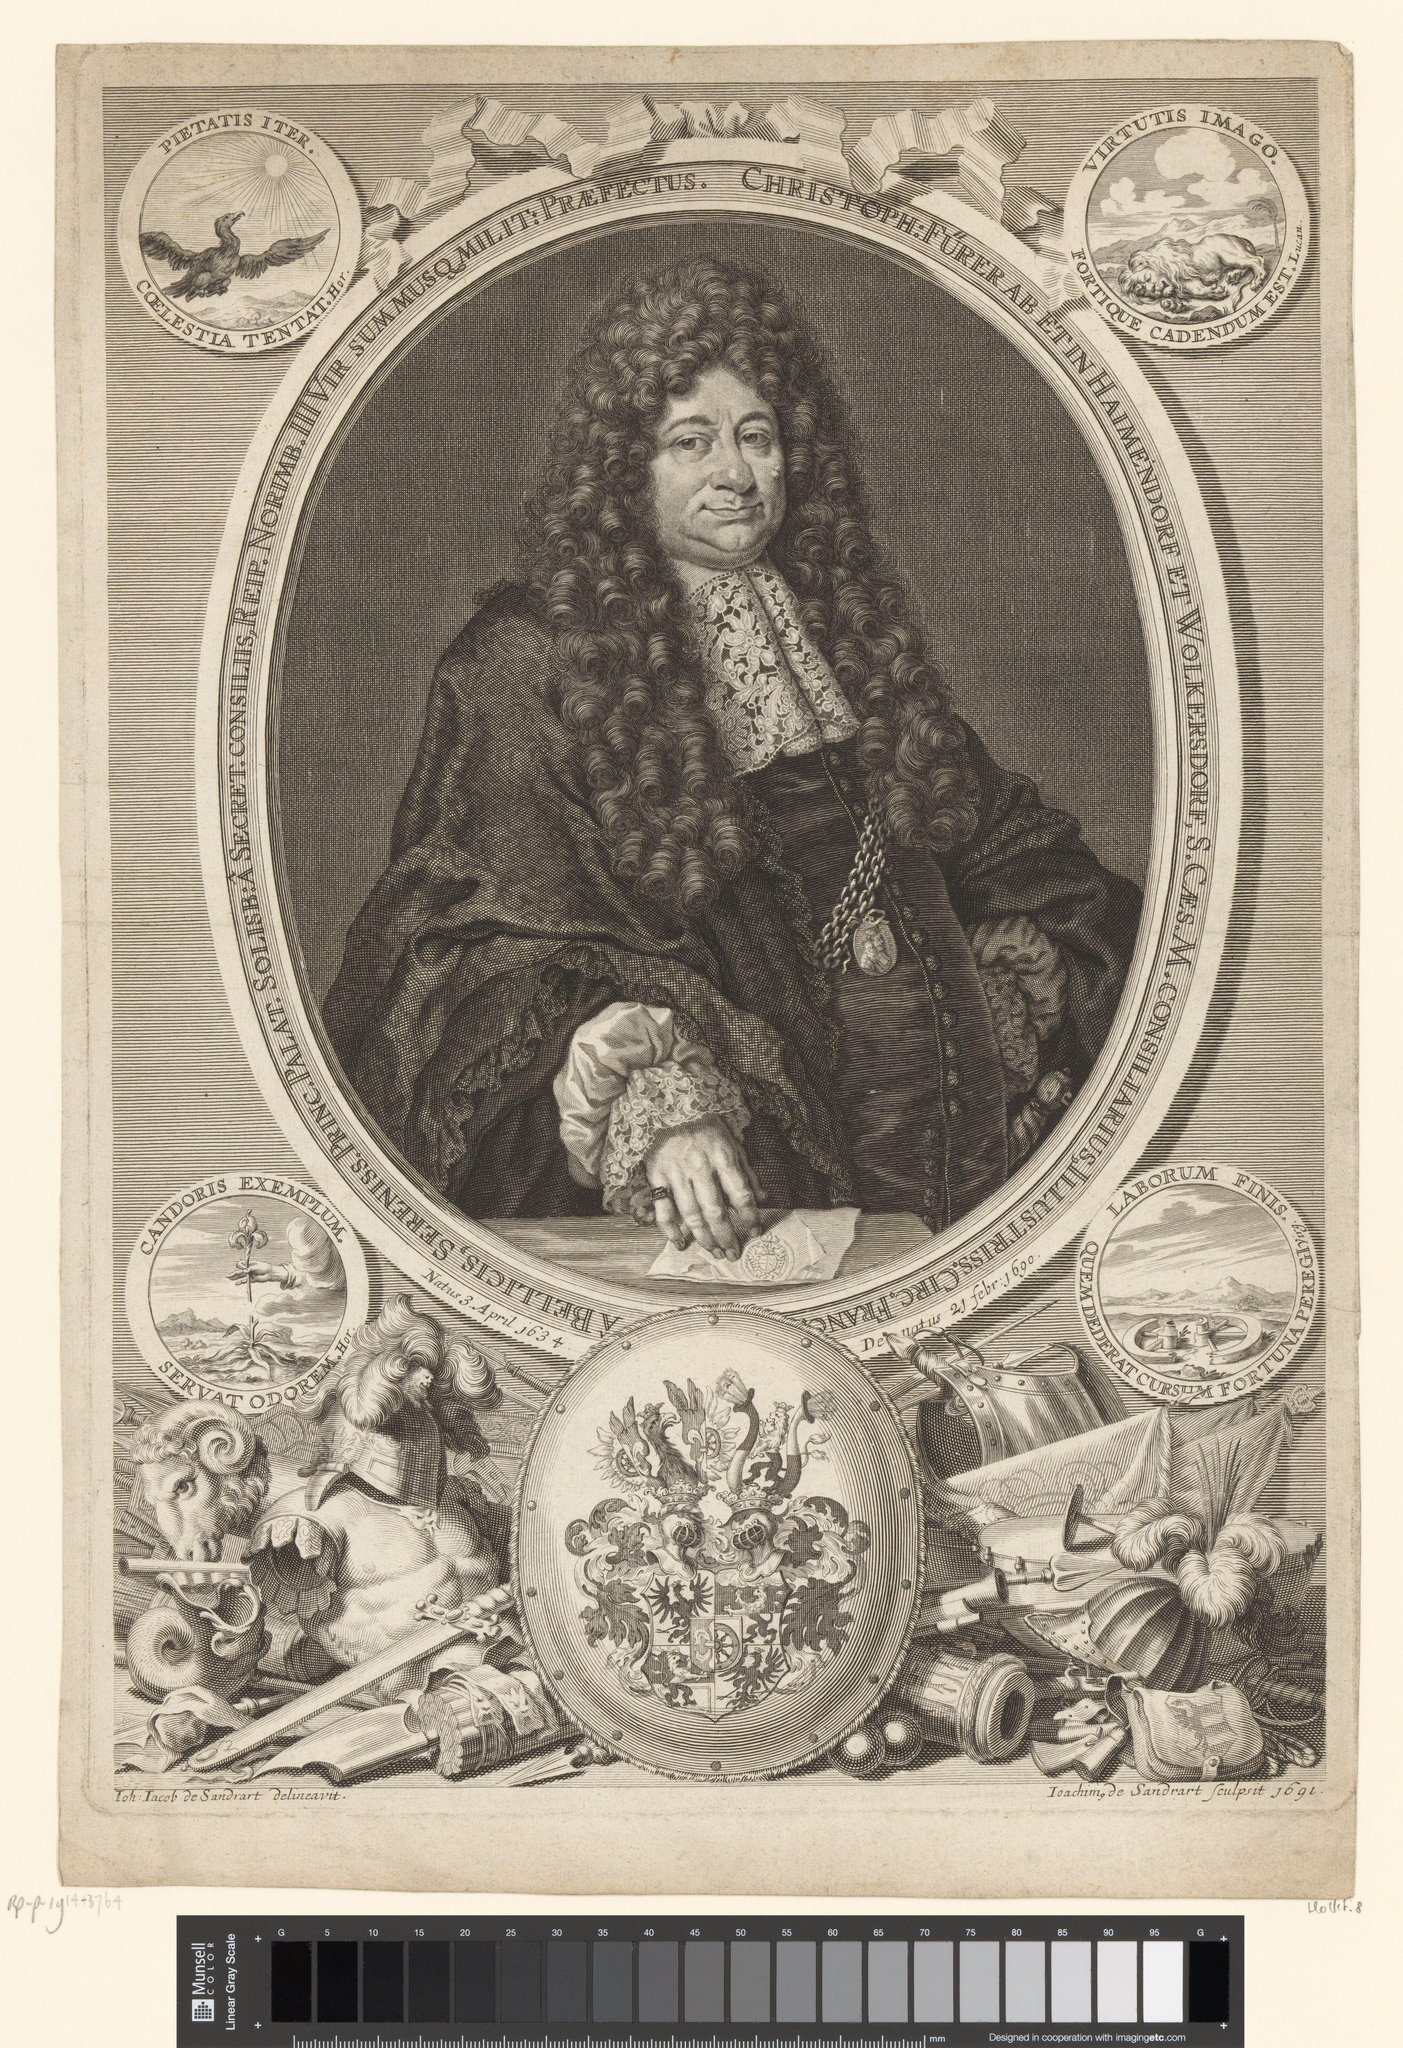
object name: print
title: Portret van Christoph IV Fürer von Haimendorf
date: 1691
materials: paper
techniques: engraving, etching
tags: historical persons, symbols, allegories of war; 'guerra' (ripa), abstract ideas and concepts (+ emblematical representation of concept), armorial bearing, heraldry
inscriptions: collector's mark: Lugt 2228